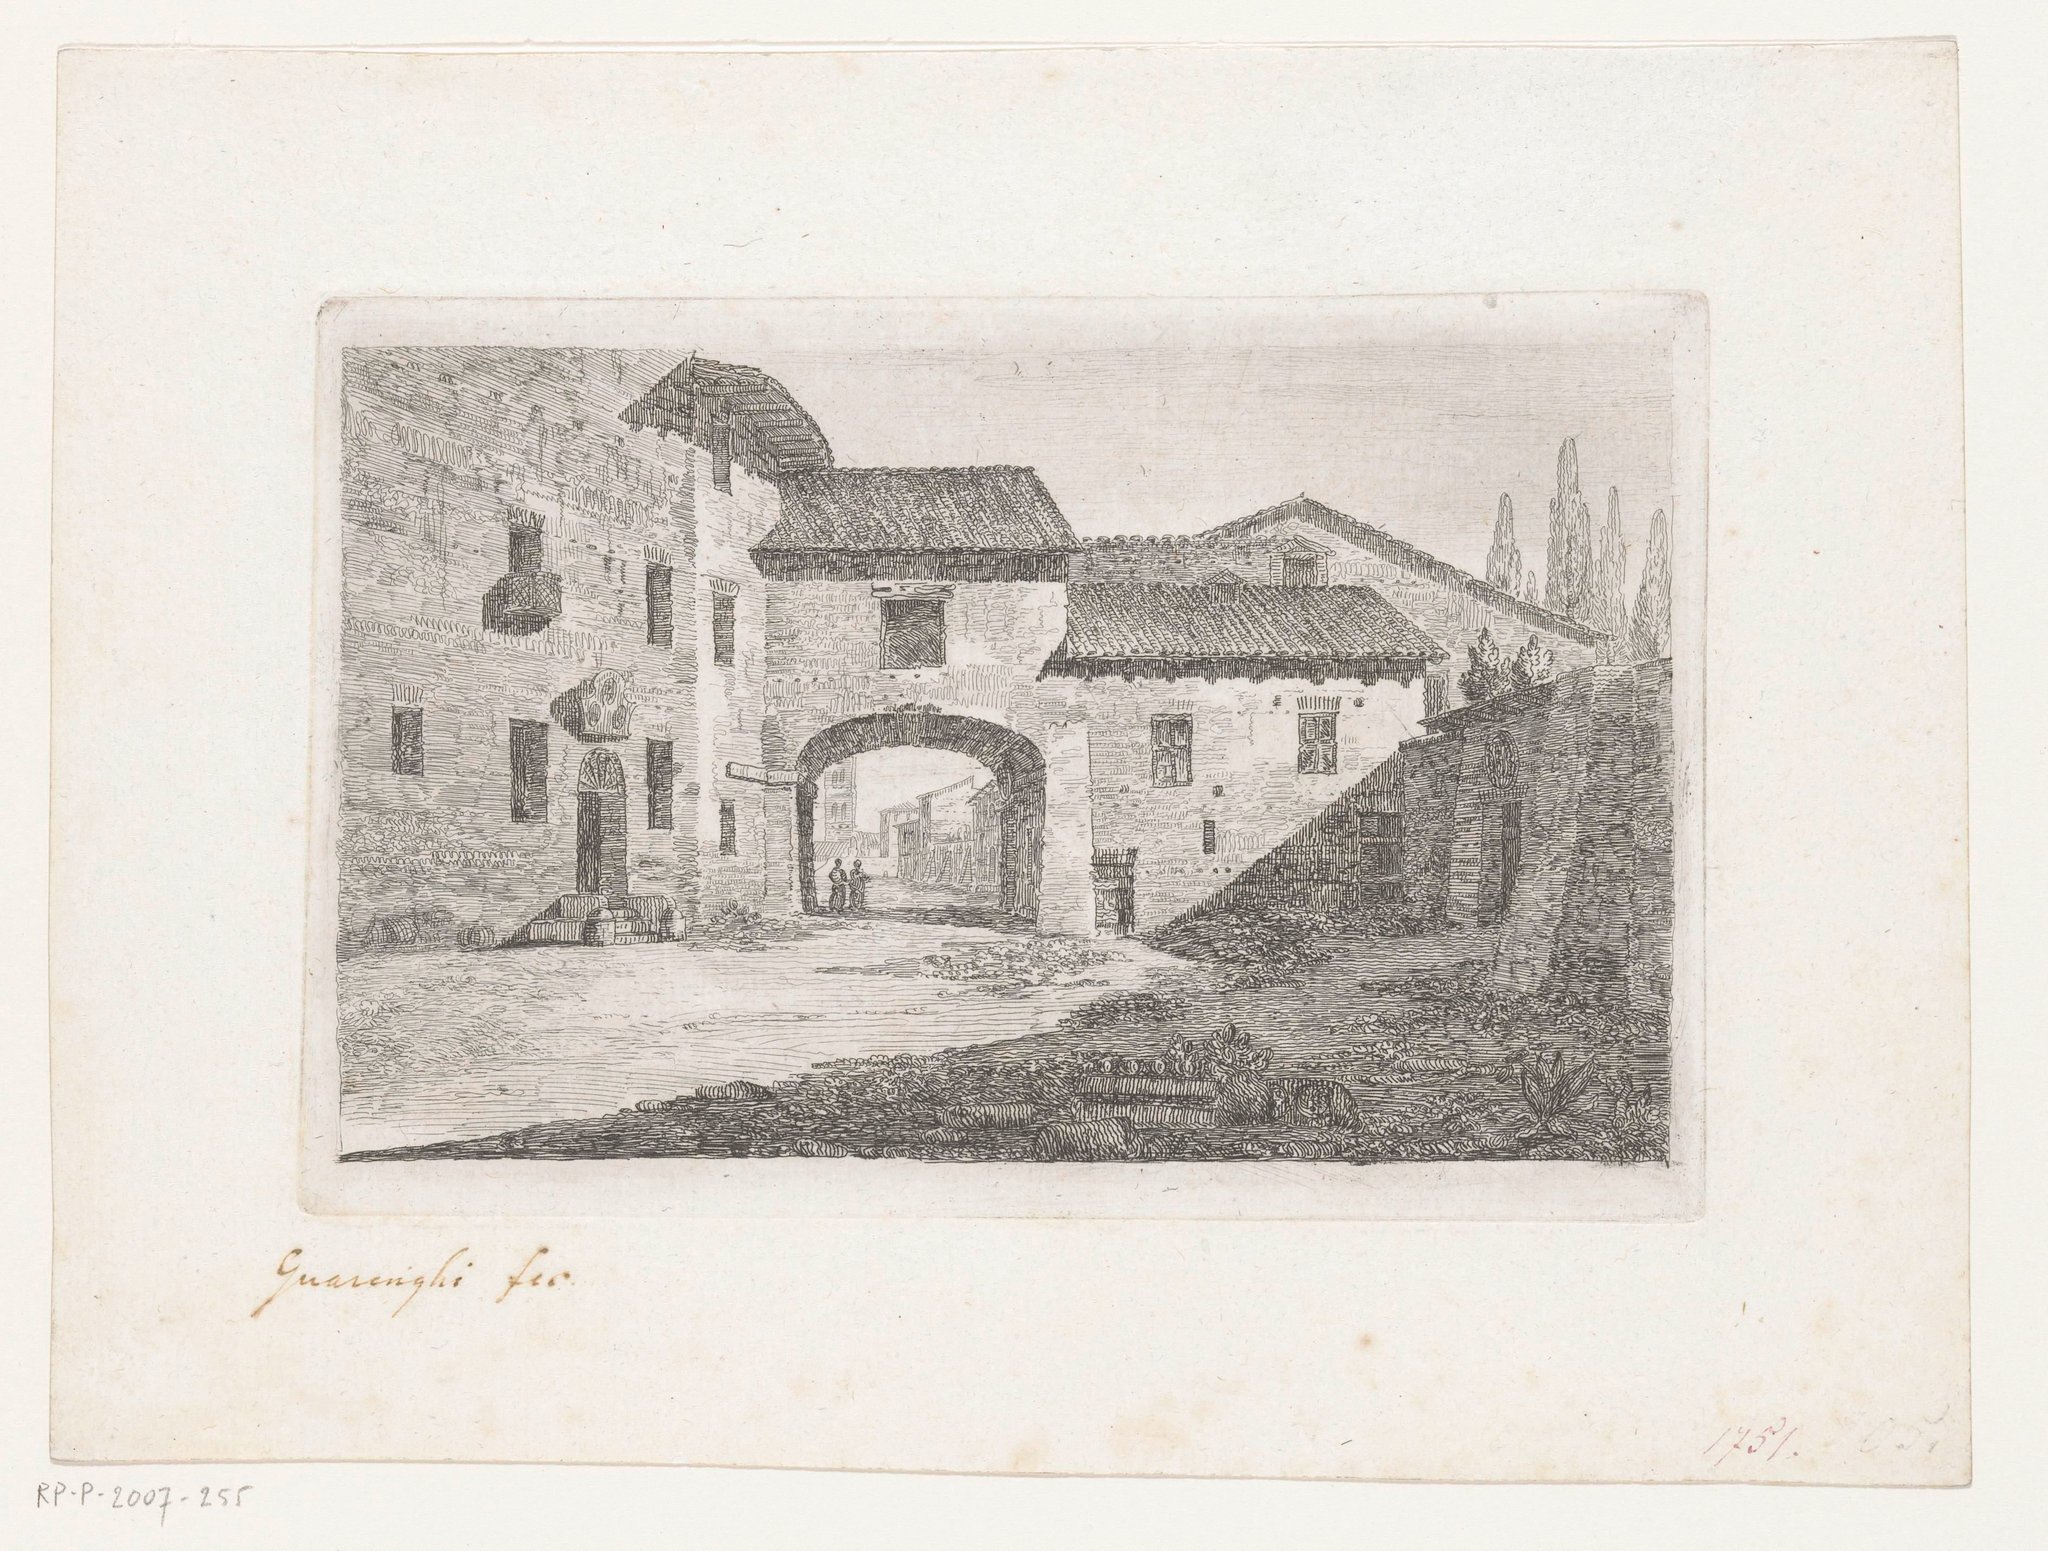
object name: print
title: Gezicht op een stadspoort in Rome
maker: giacomo quarenghi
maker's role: draughtsman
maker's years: 1744-1817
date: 1751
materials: paper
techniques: etching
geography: italy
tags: city-view, and landscape with man-made constructions, city-gate, rome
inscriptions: collector's mark: Lugt 2760, collector's mark: Lugt 2228